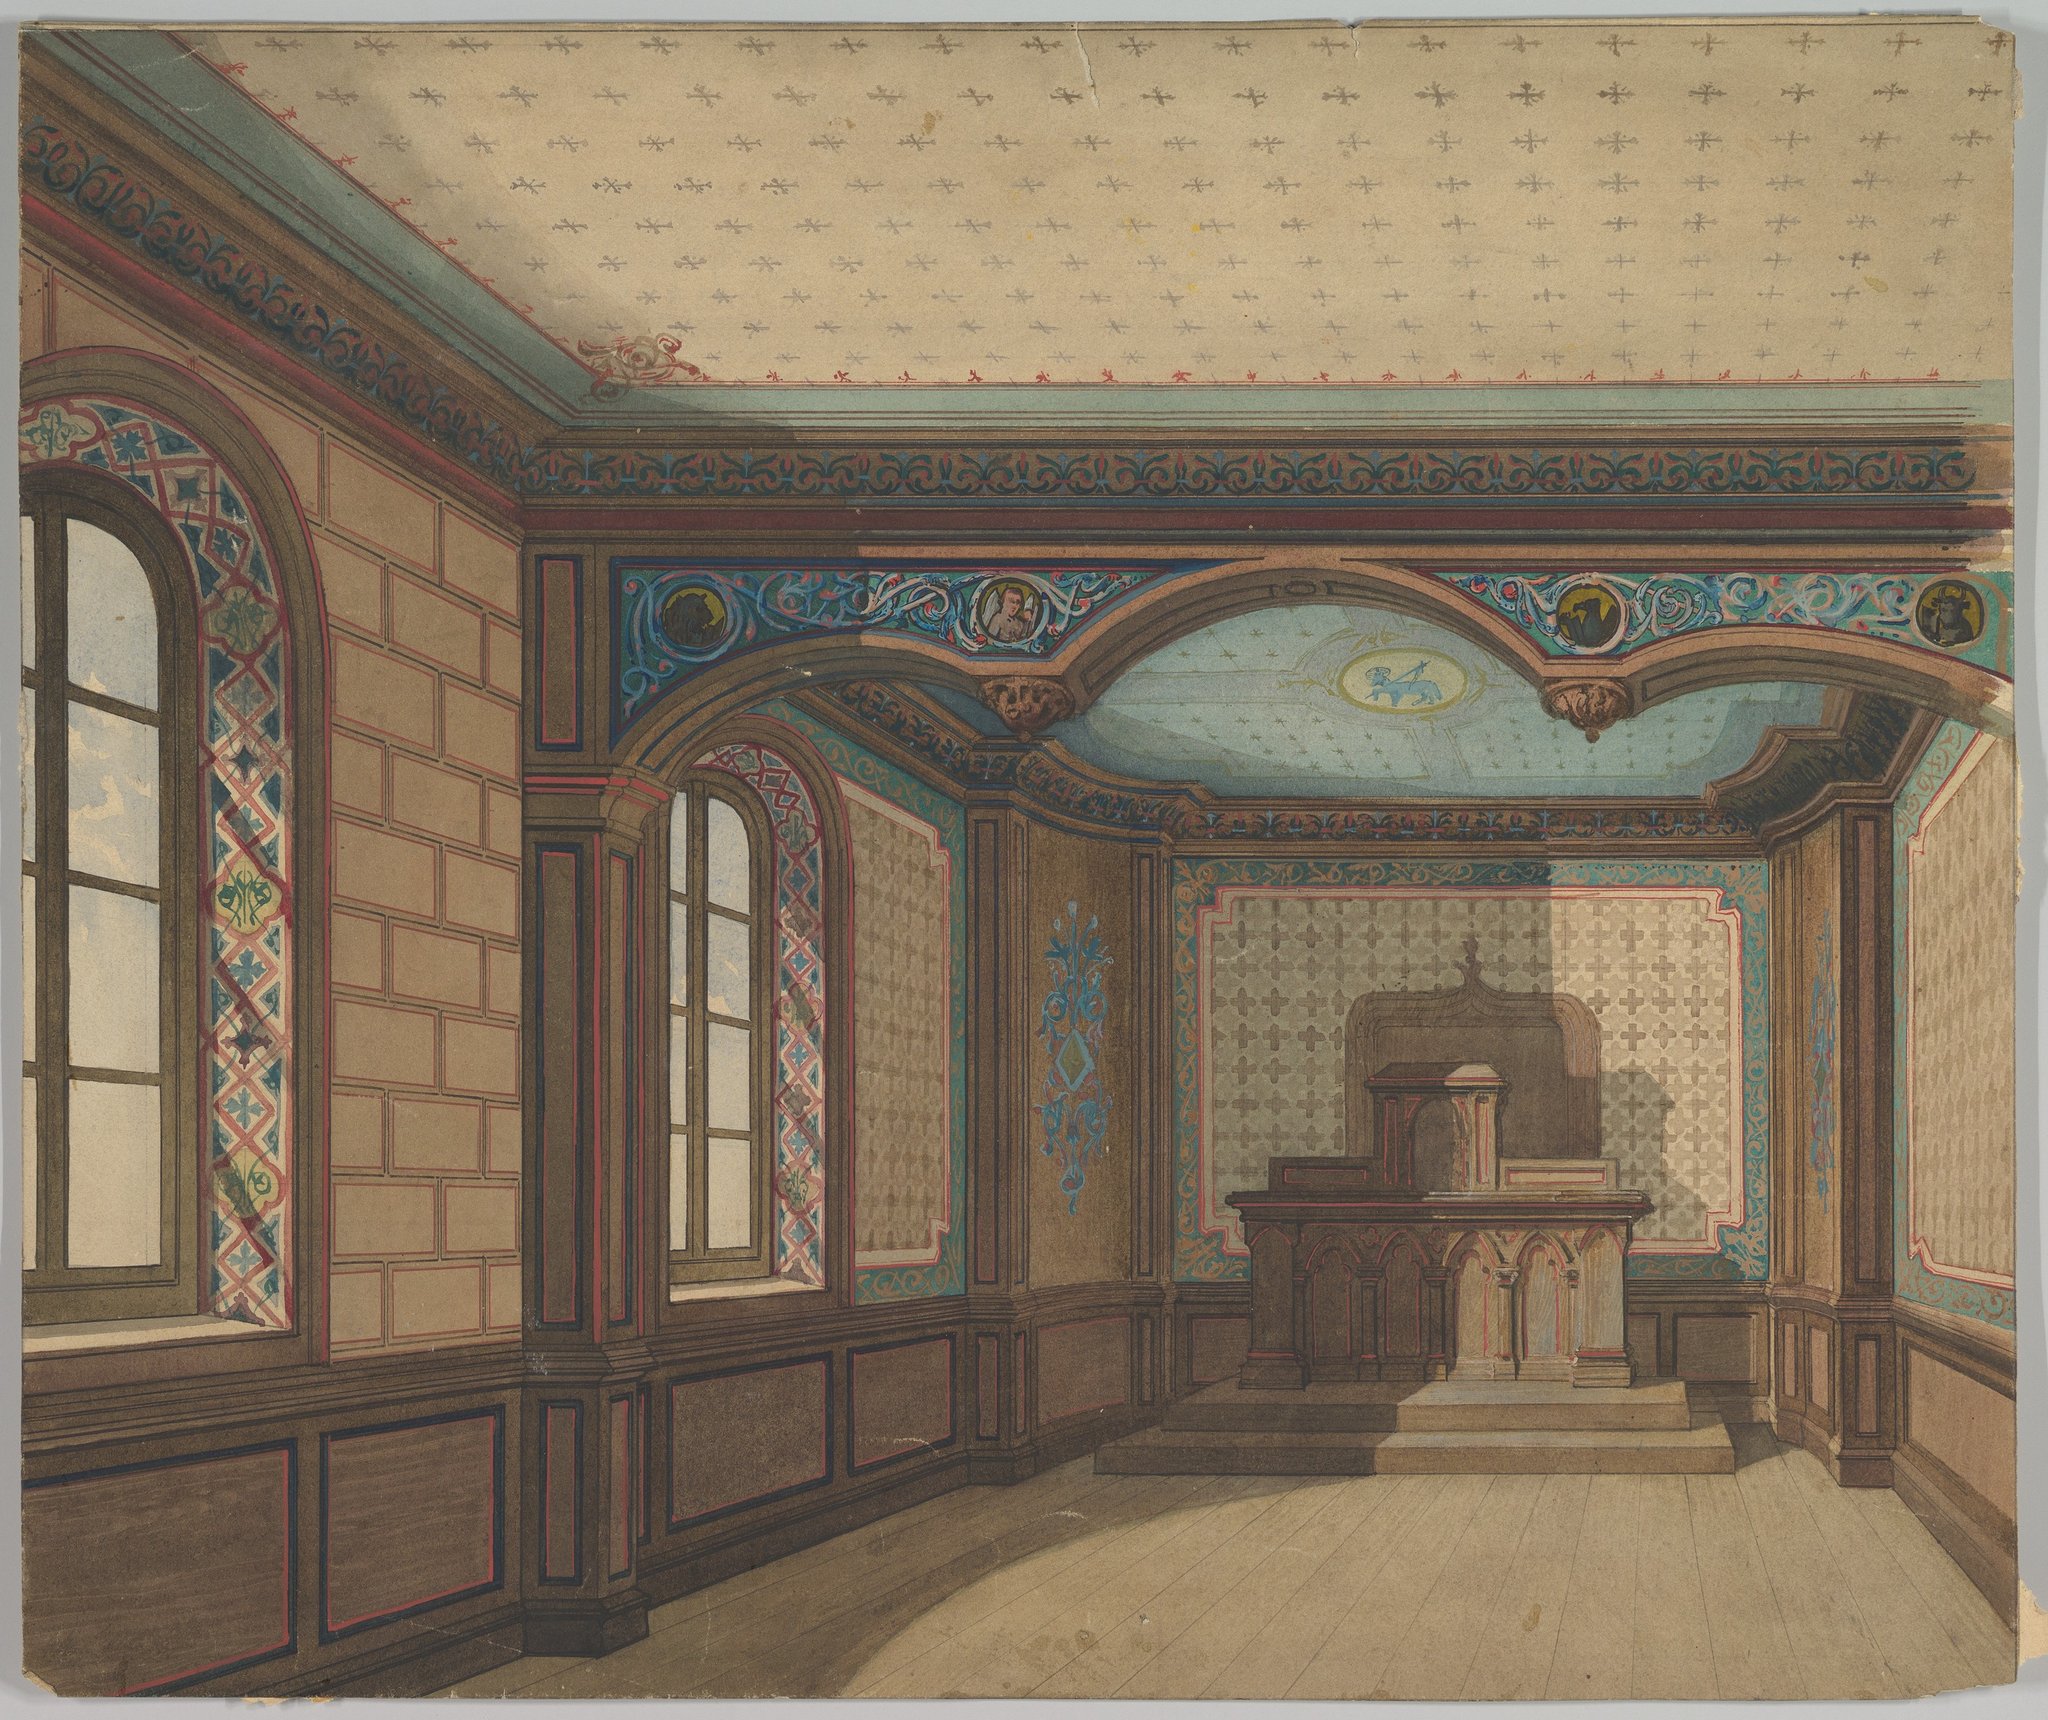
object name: drawing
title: Design for a Stage Set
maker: eugène cicéri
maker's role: artist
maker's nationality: french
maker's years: 1813-1890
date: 1830-1890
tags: interiors,stage design